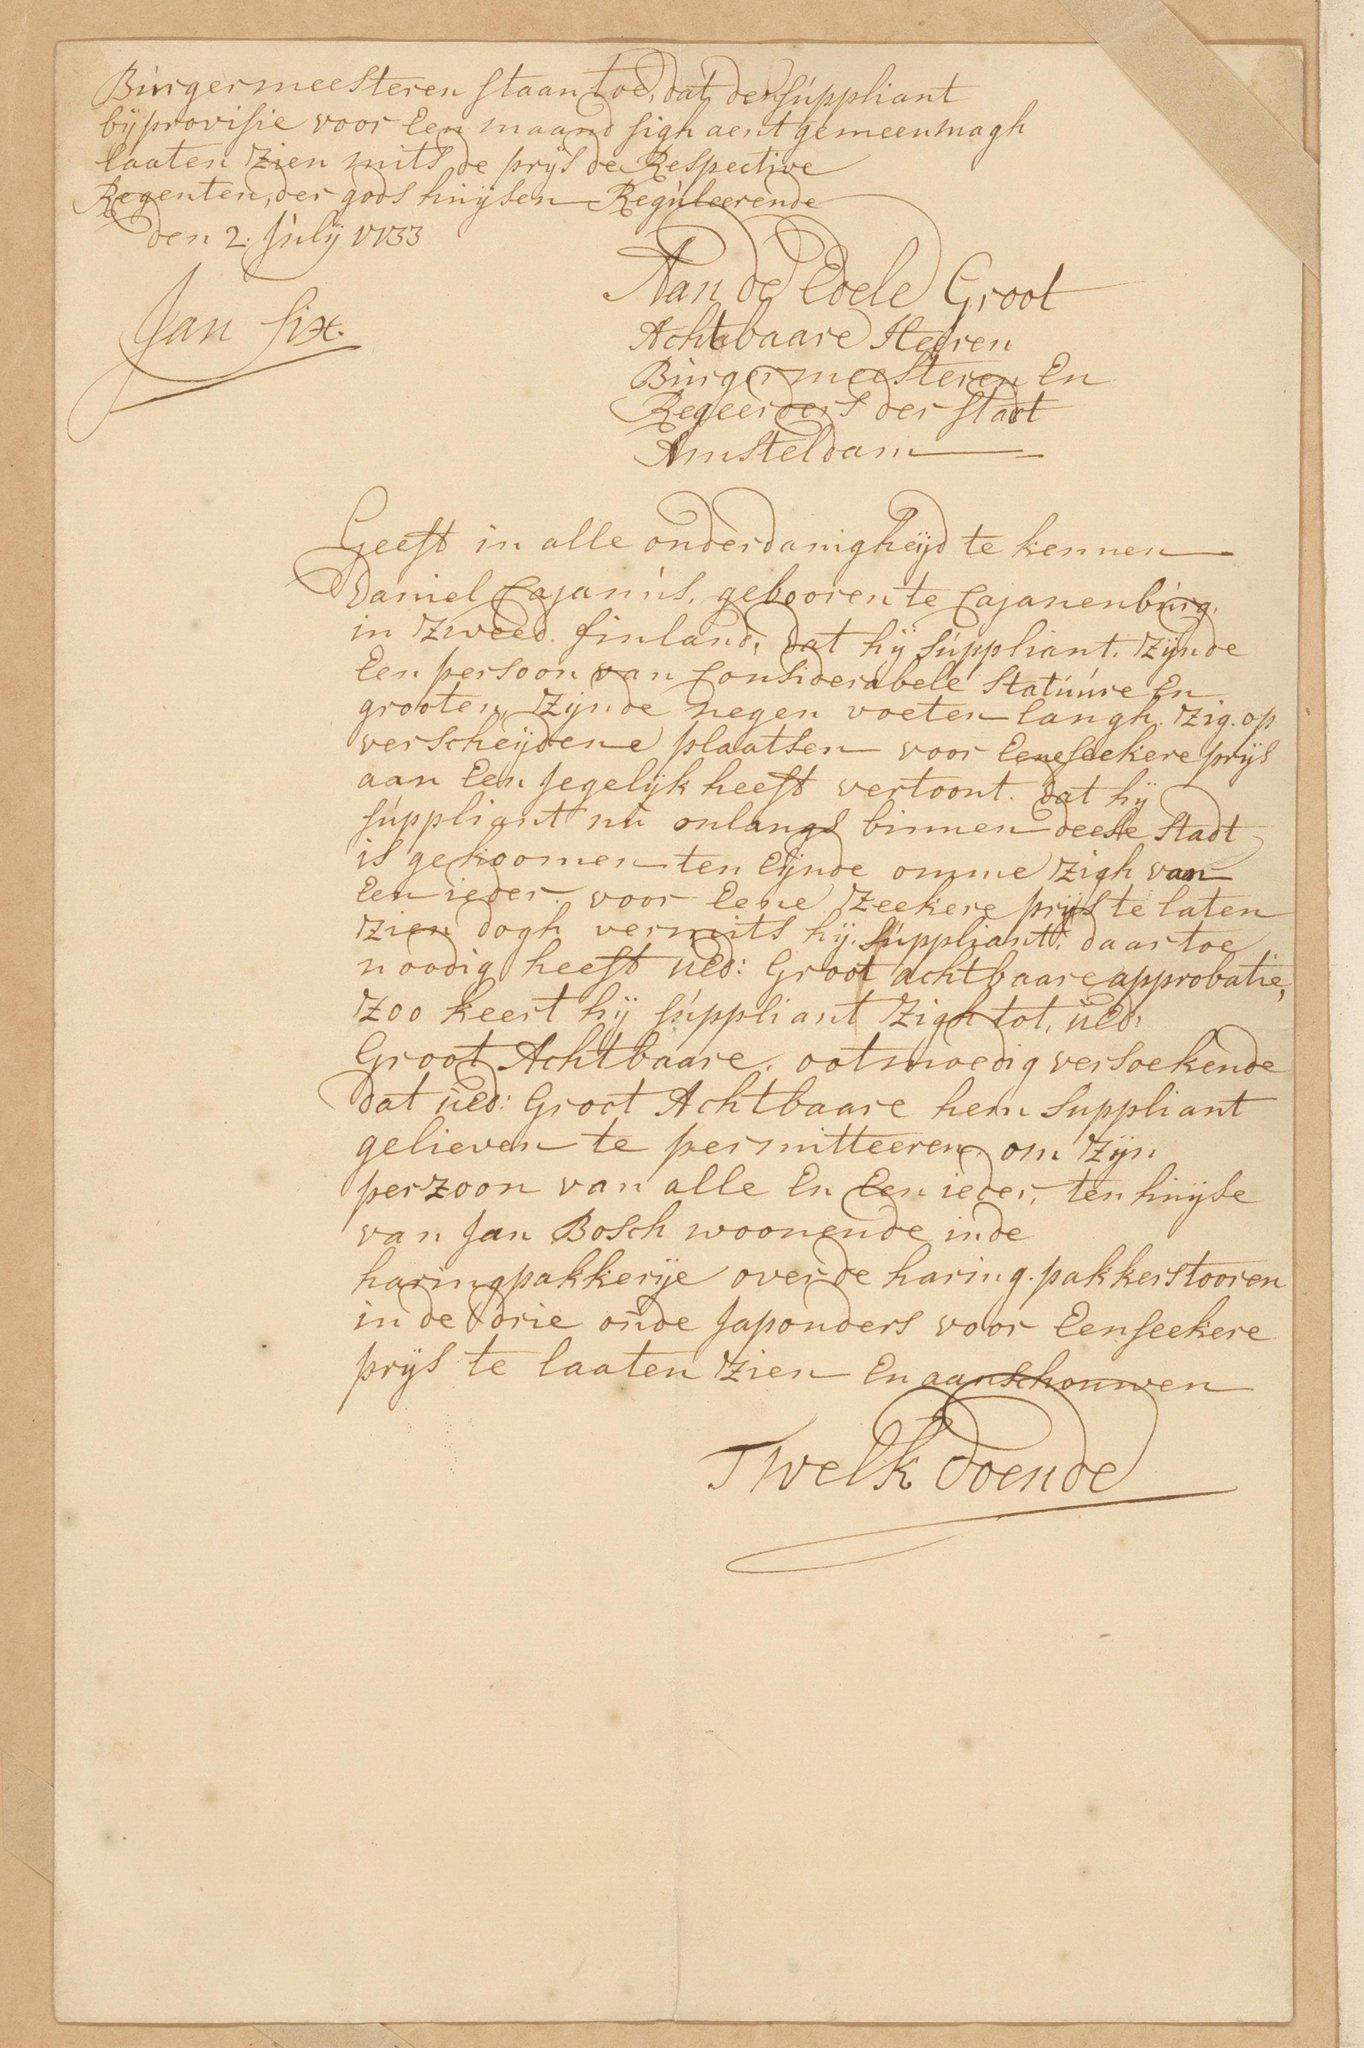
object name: letter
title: Vergunning voor Daniel Cajanus om zichzelf tentoon te stellen in de stad Amsterdam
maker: jan six (1668-1750)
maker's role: mayor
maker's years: 1668-1750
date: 1733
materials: ink, paper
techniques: pen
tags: human monstrosities ~ freak show, giants, colossi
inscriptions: collector's mark: Lugt 1641, stamp, stamp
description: Vergunning voor Daniel Cajanus om zichzelf tentoon te stellen in de stad Amsterdam. Toestemming is verleend door burgemeester Jan Six (1668-1750). Onderwerpsrubrieken binnen de Atlas Zeden en Gewoonten: Zeden en Gewoonten in Engeren Zin. Volksleven. Volksfeesten. Kermistypen, wondermenschen en dergelijken.